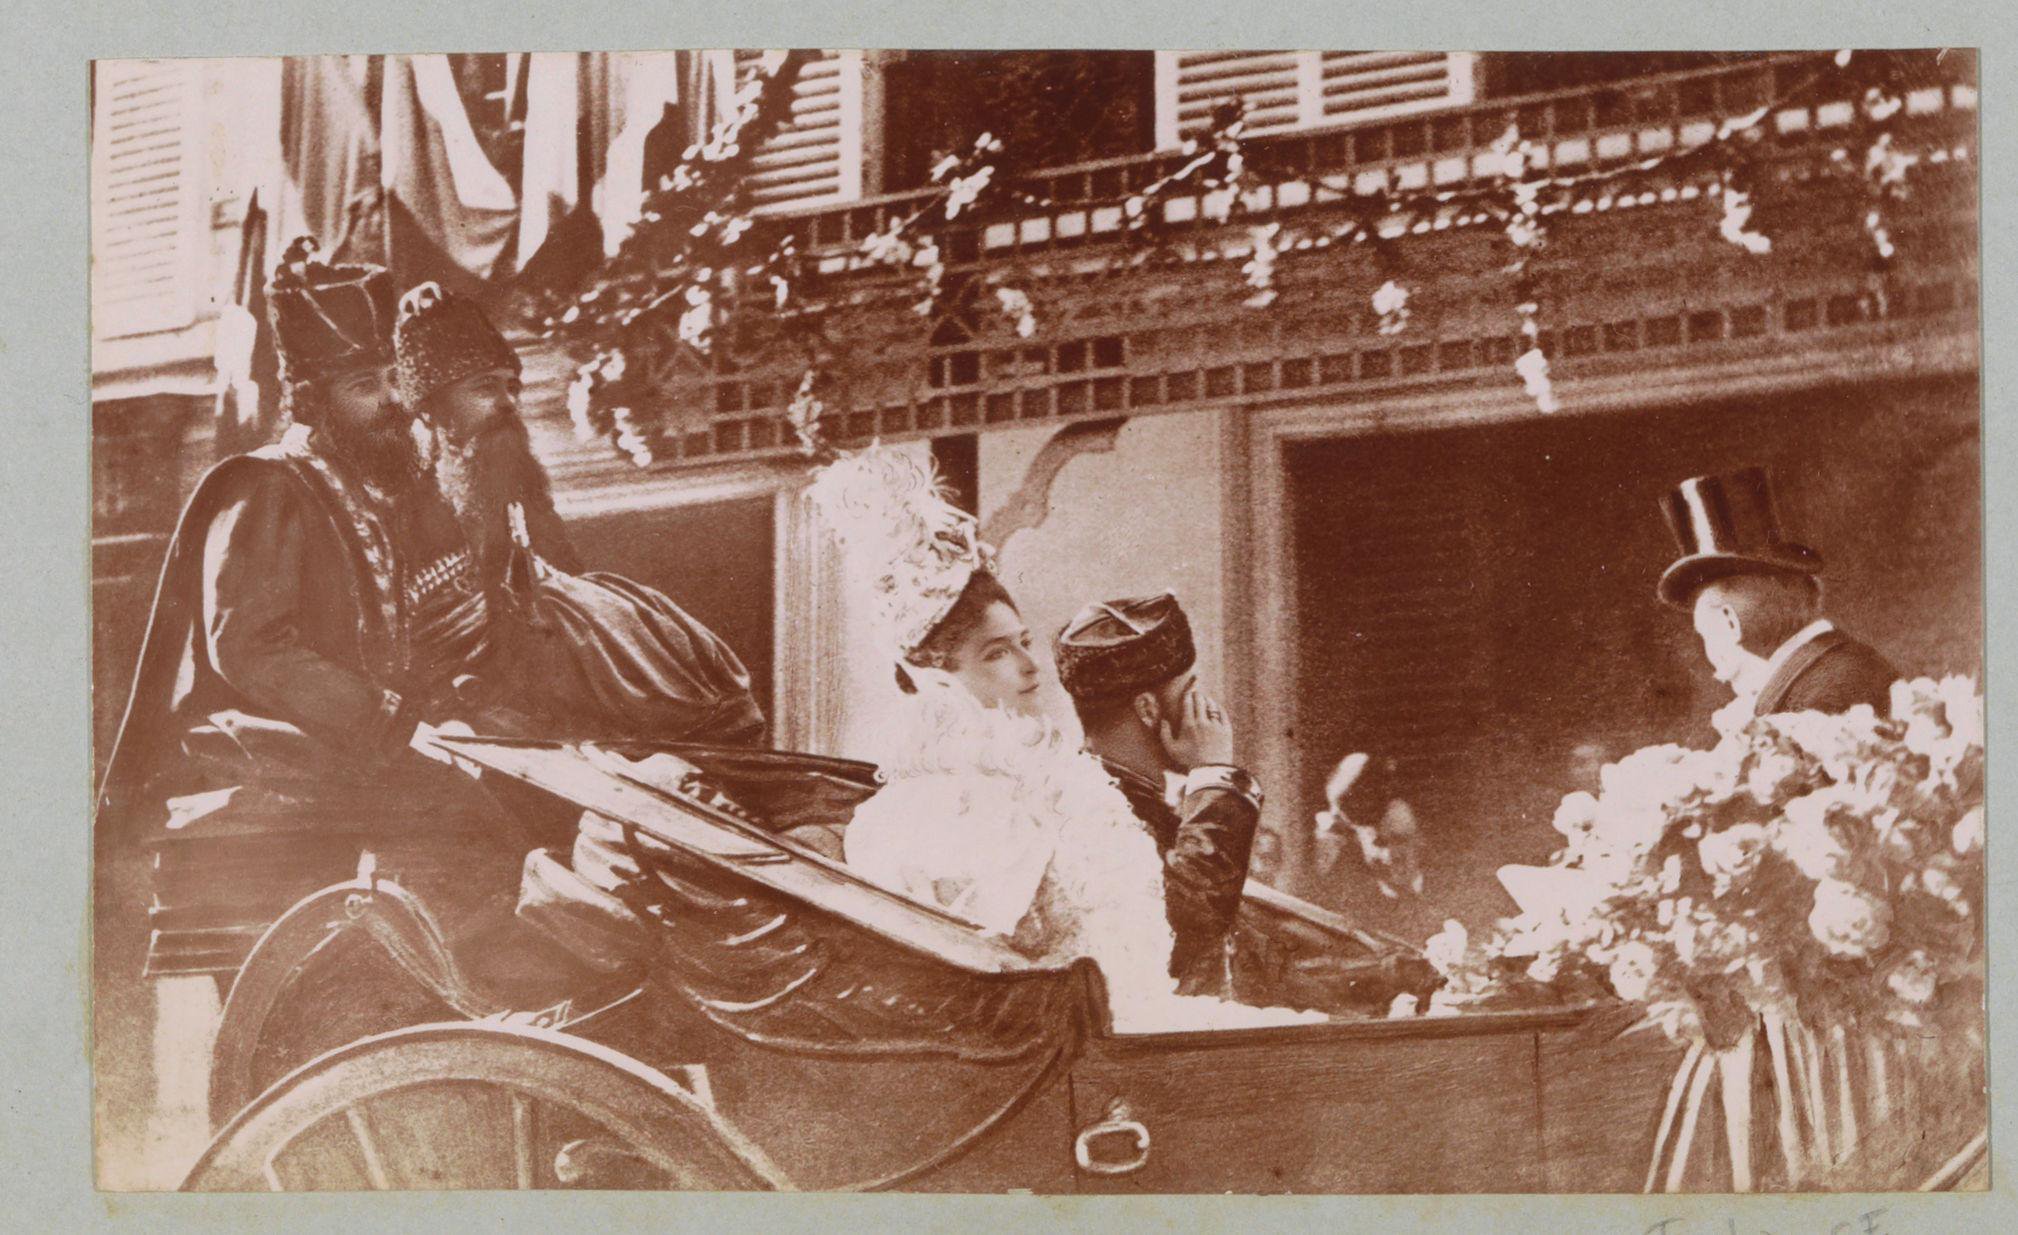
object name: reproduction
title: Fotoreproductie van (vermoedelijk) een tekening, voorstellend tsaar Nicolaas II van Rusland en tsarina Alexandra Fjodorovna in een rijtuig tijdens hun bezoek aan Parijs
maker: delizy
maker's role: manufacturer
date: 1896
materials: paper, photographic support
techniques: gelatin silver print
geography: paris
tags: land forces (+ cavalry, horsemen), animal traction, animal-drawn vehicle (carriage etc.), ruler, sovereign - bb - female ruler, festivities (+ parade, pageant, cavalcade ~ festive activities), ruler, sovereign, paris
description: Onderdeel van Fotoalbum van een Franse amateurfotograaf met opnames van uitstapjes in Frankrijk, Spanje, België, Luxemburg en Nederland, de eerste automobielen en autoraces.